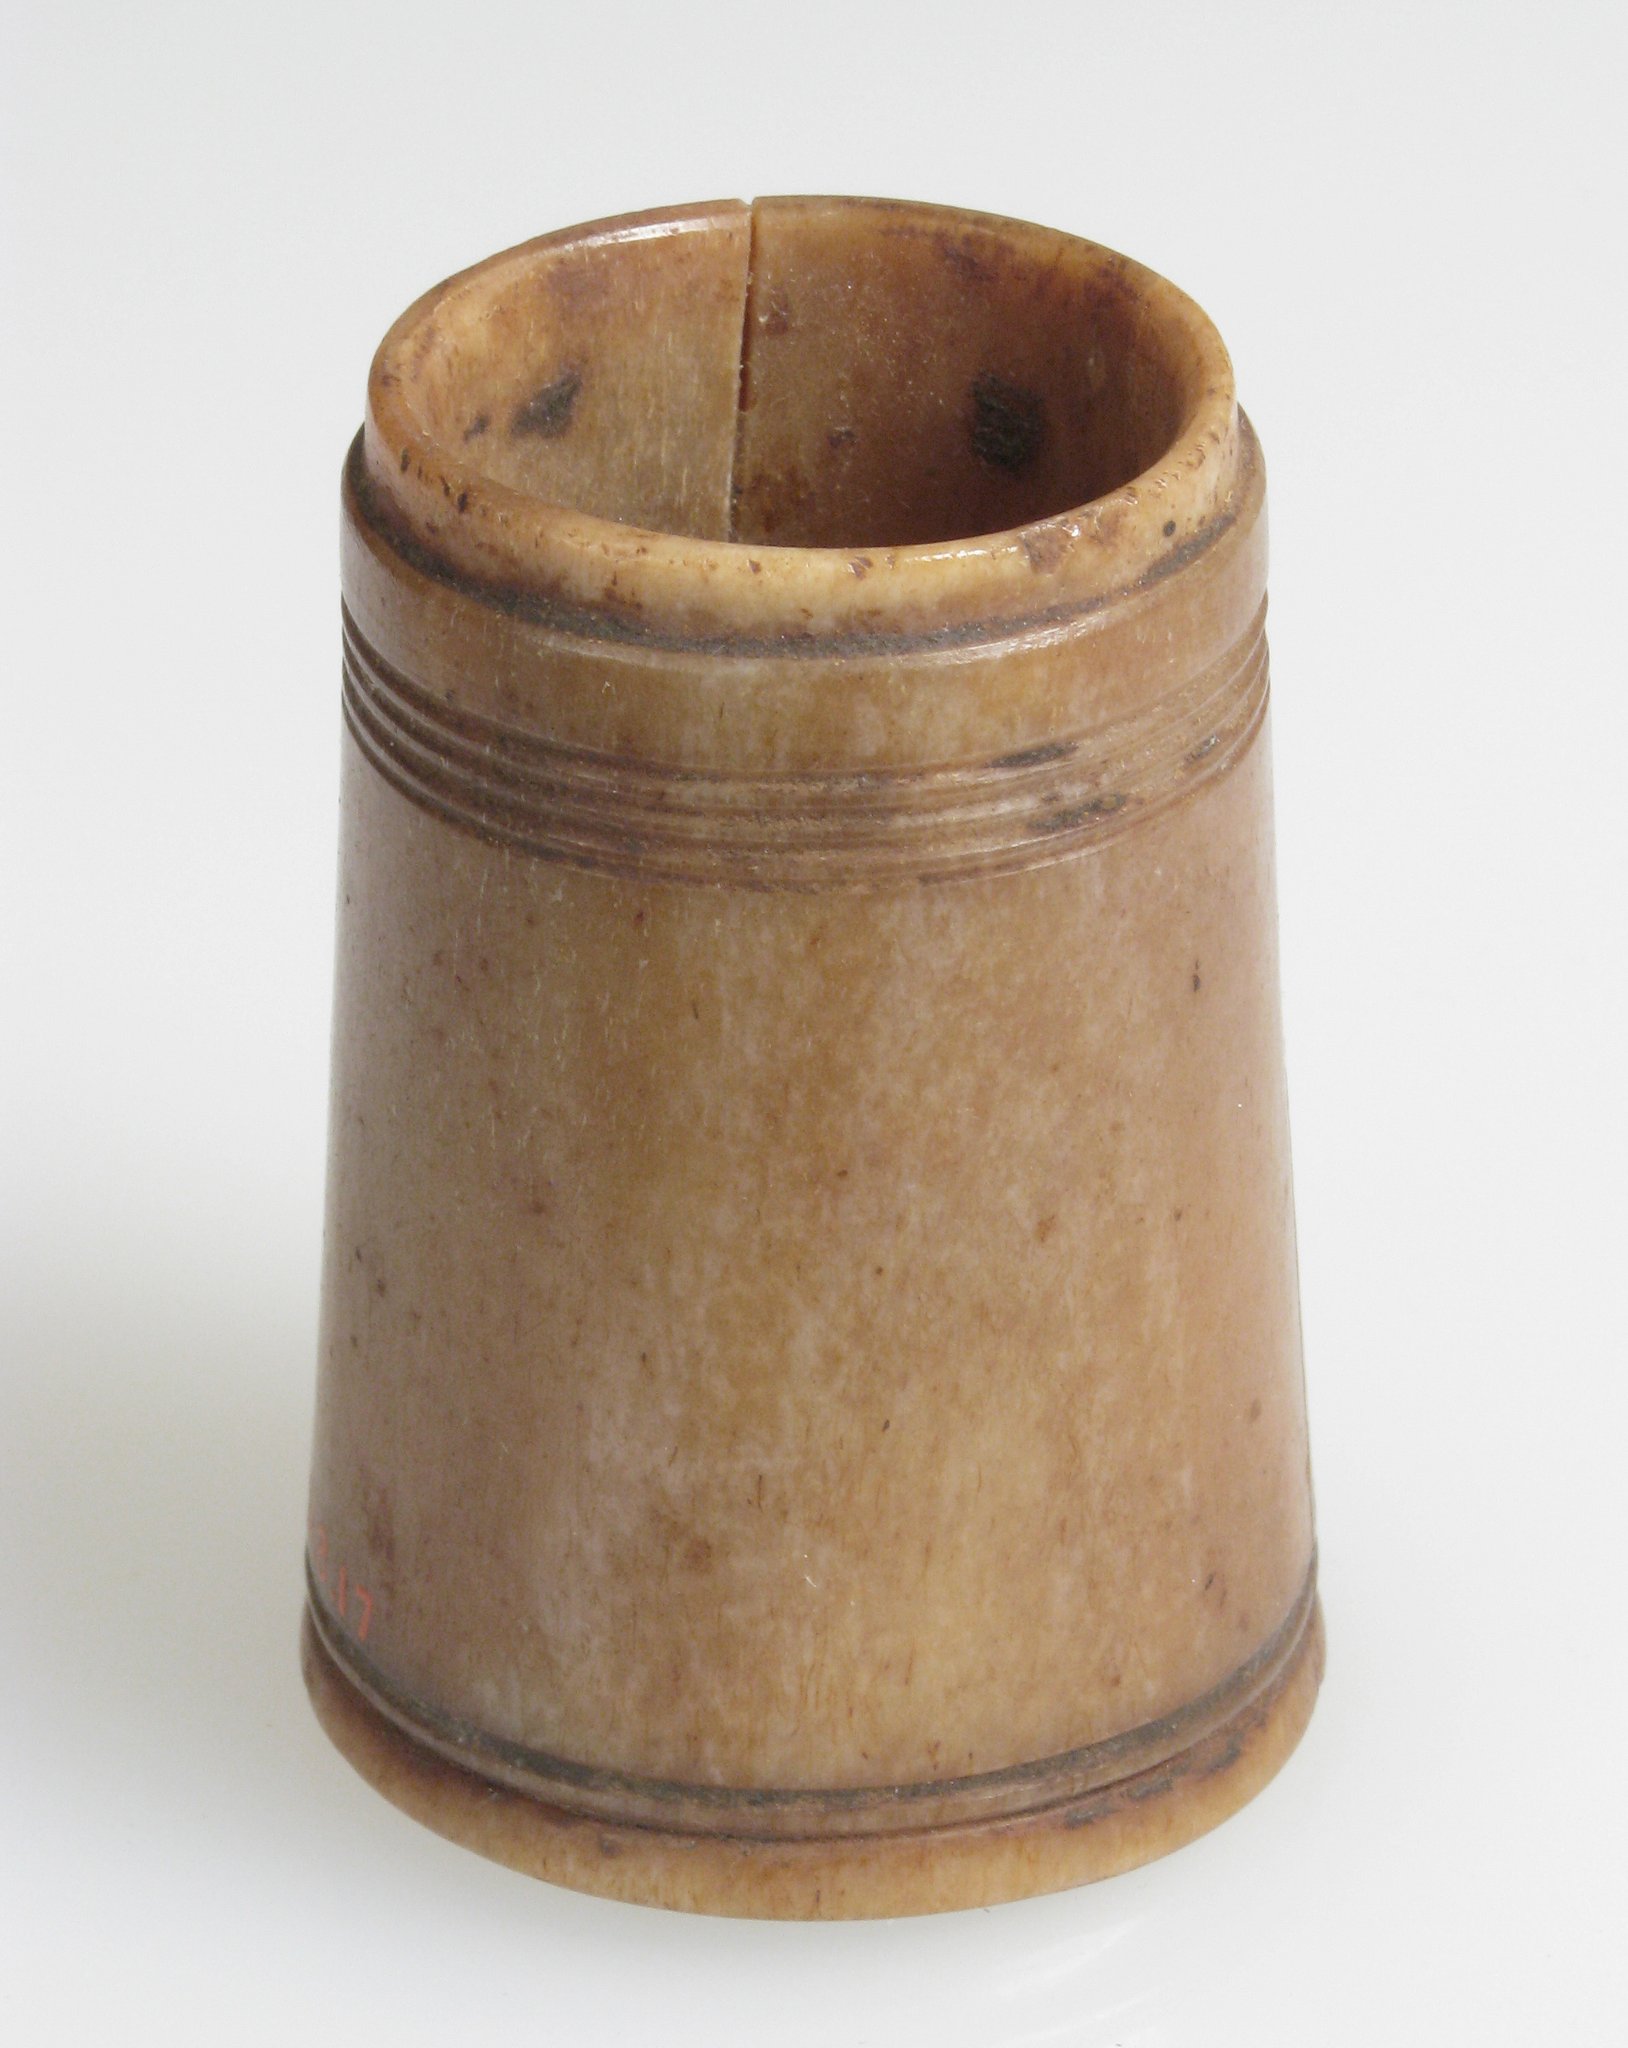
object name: jar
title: Ointment Jar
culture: coptic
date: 301-700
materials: bone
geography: egypt